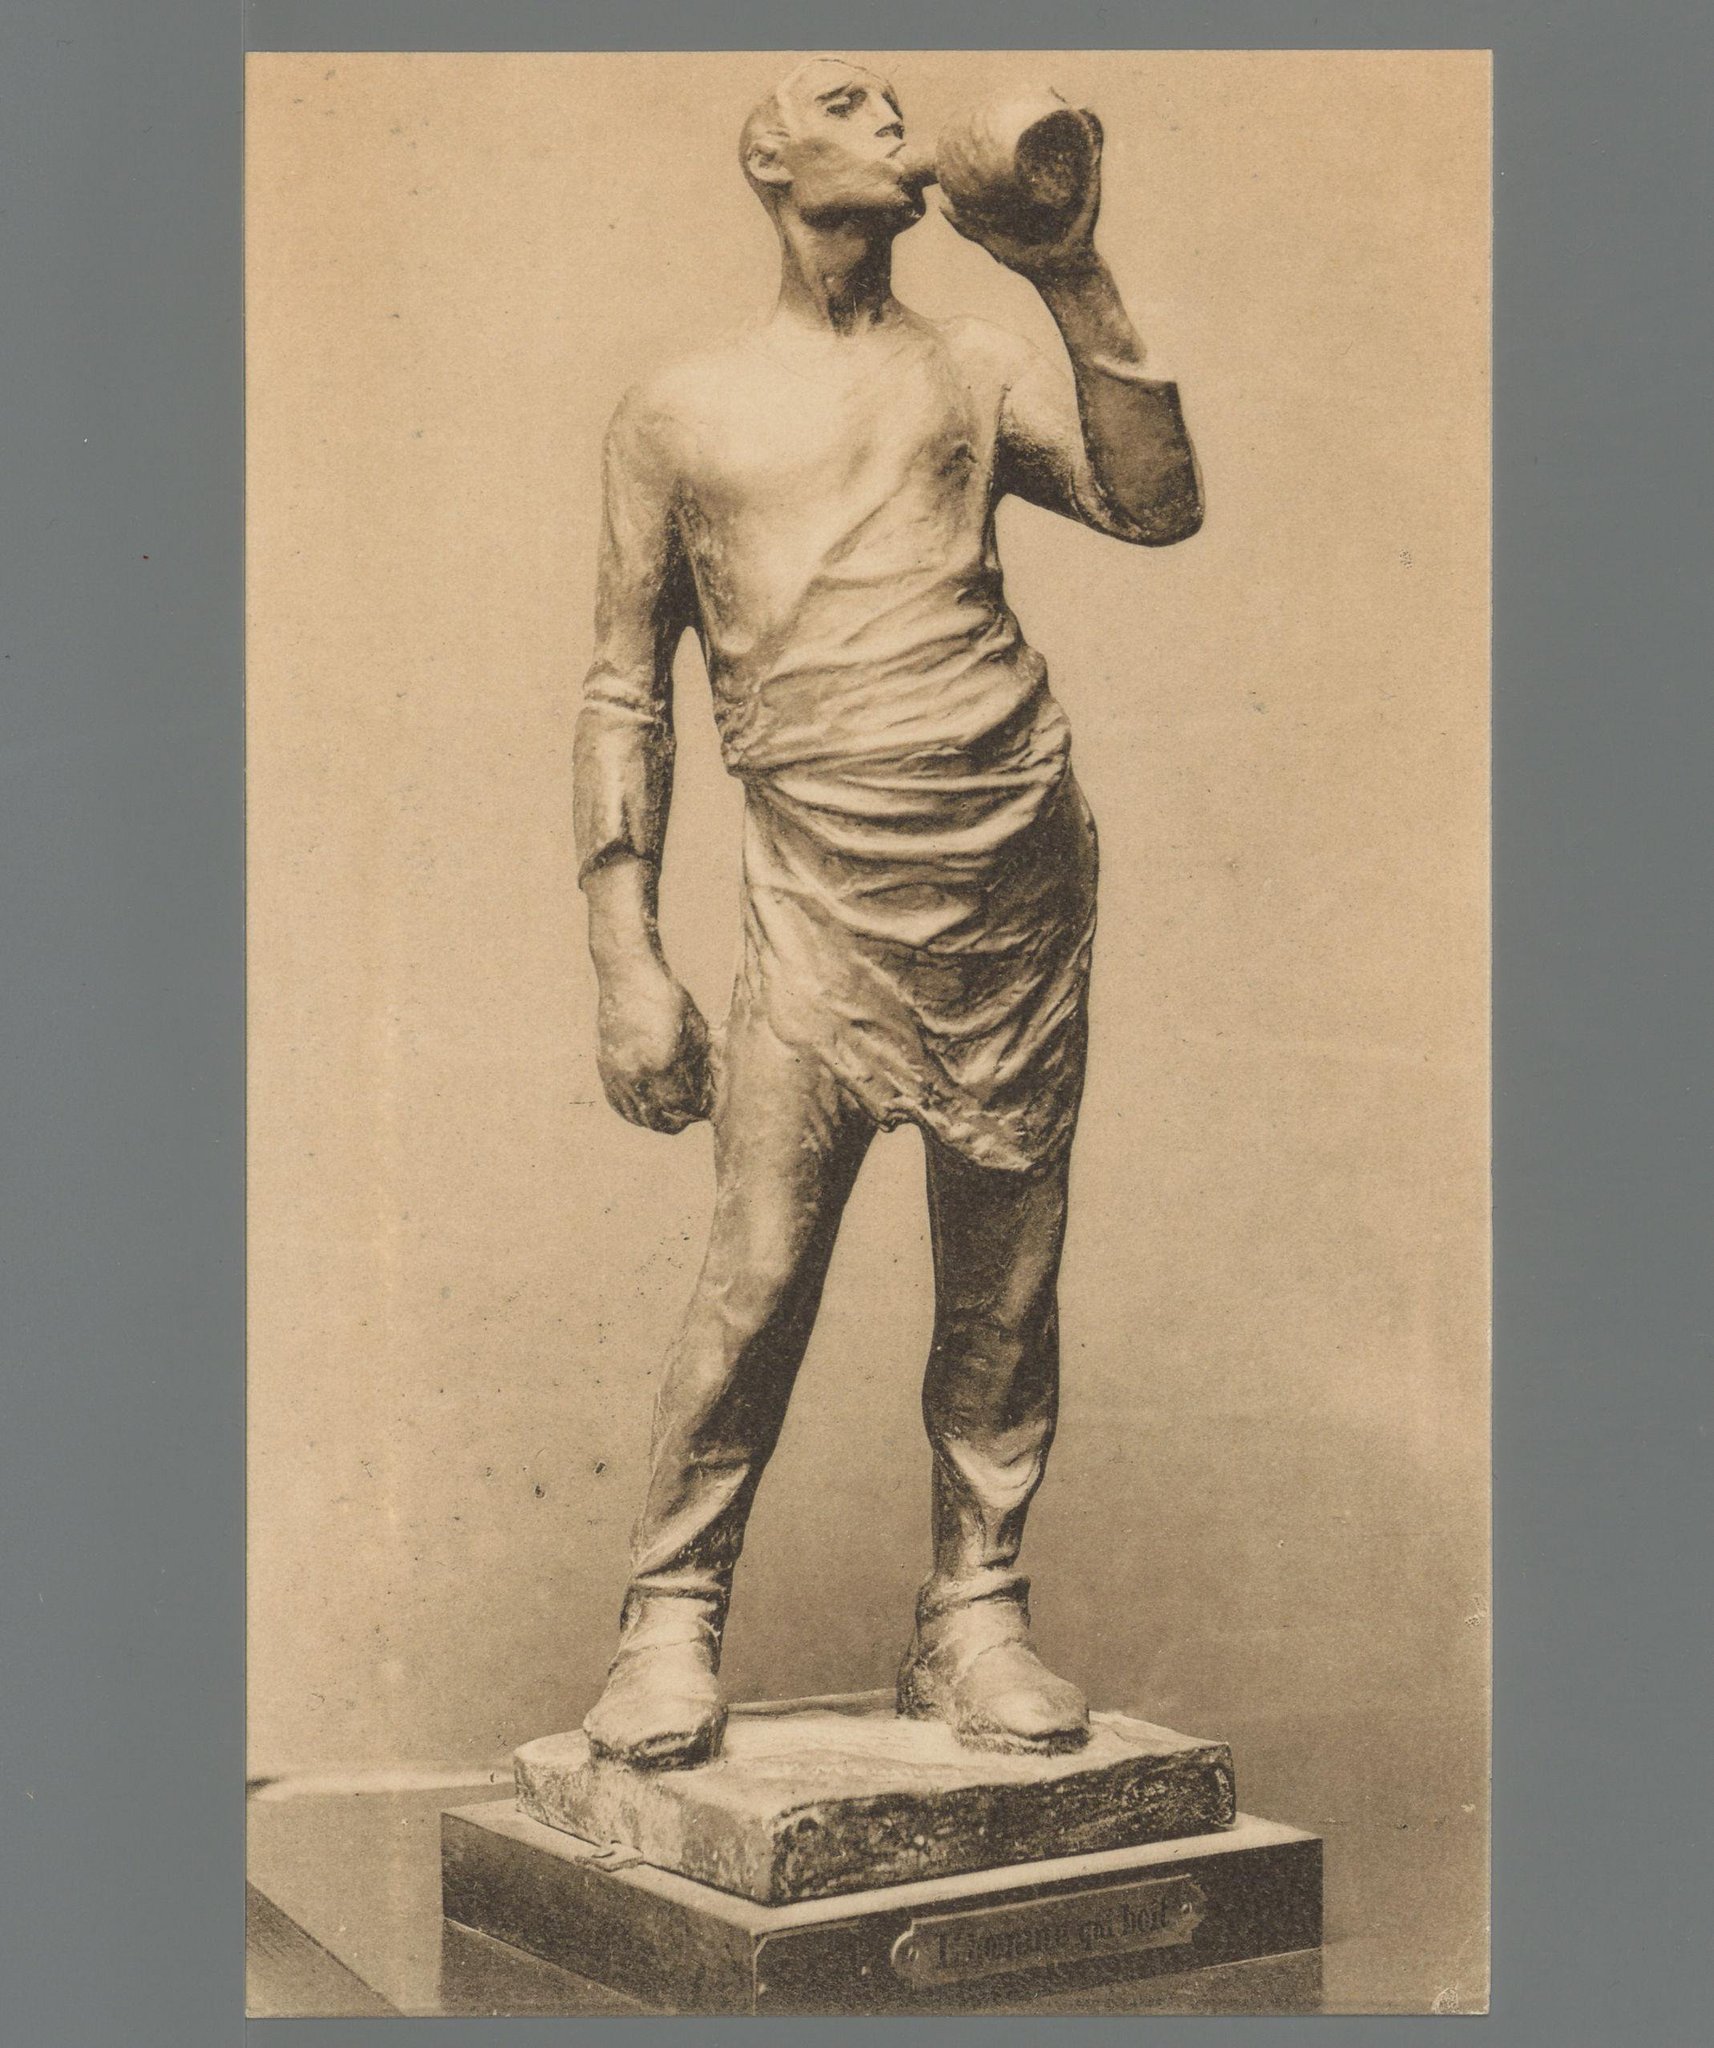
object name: ansichtkaart, prentbriefkaart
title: Musée de Bruxelles. L'Homme qui boit par C. Meunier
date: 1906-1930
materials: cardboard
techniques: photograph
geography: paris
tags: statues, paintings, etc. ~ objects of worship in roman religion, permanent exhibition, museum, brussels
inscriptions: collector's mark: ‘AFE v S’